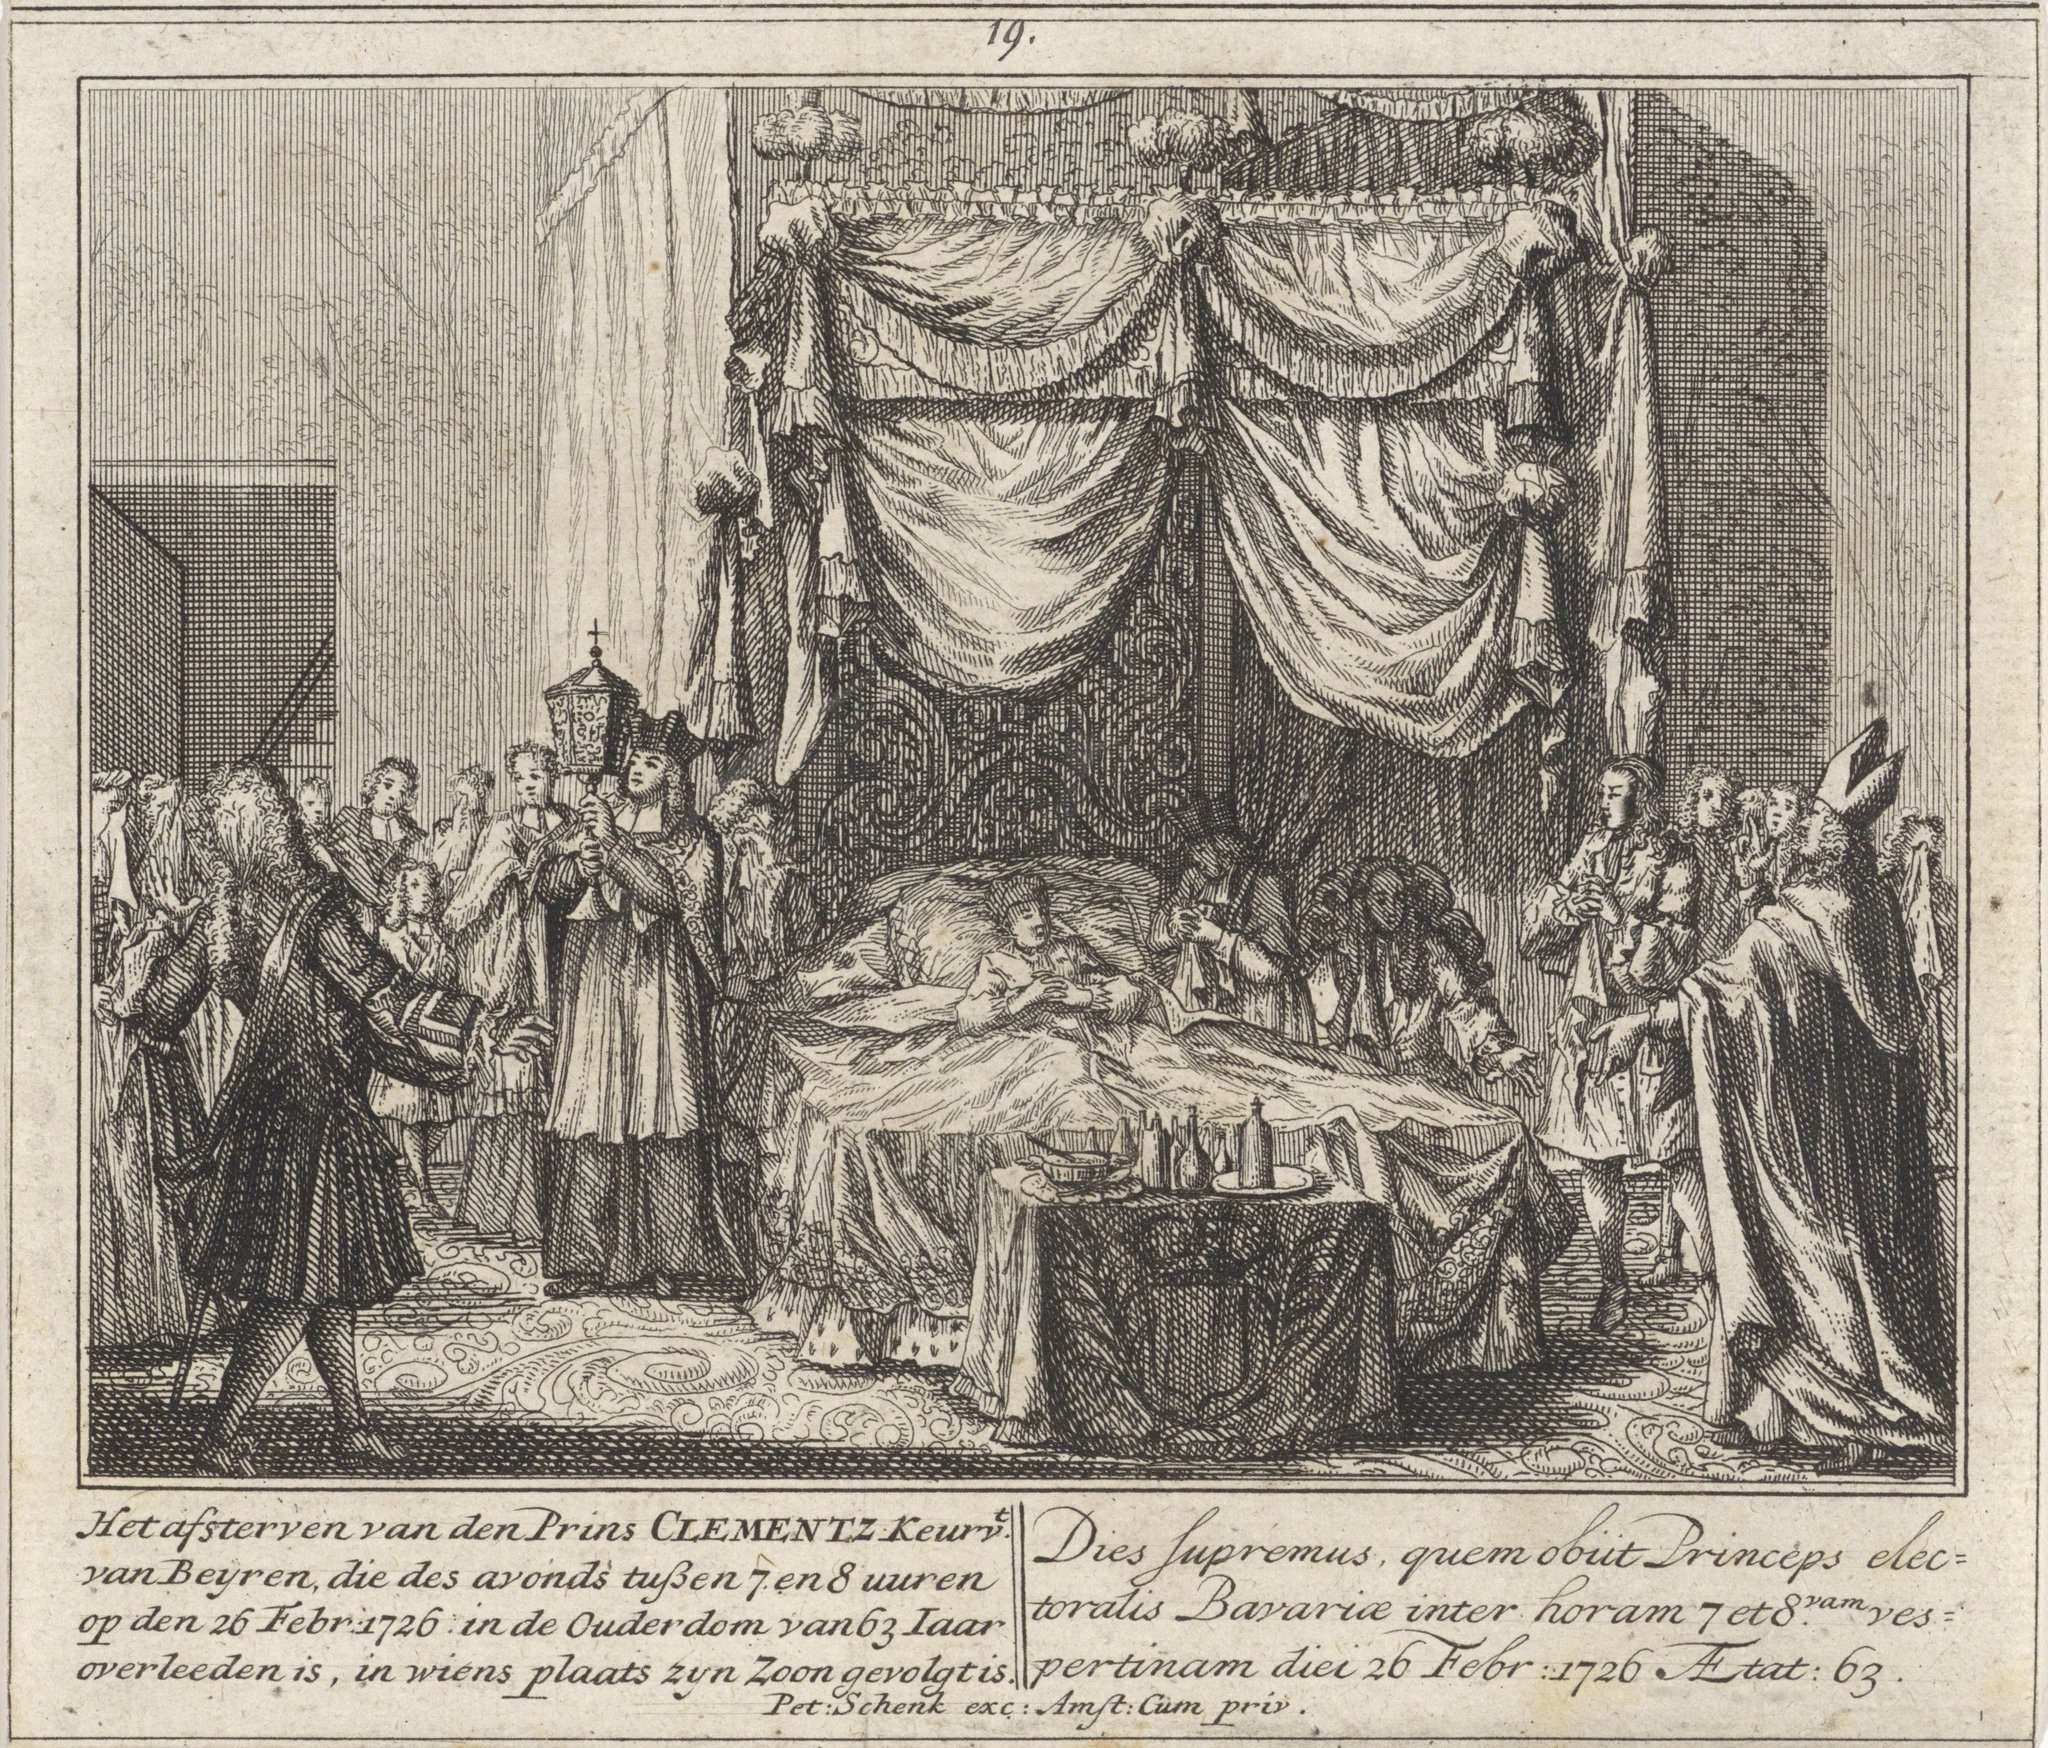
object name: book illustration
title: Het afsterven van den Prins Clementz Keurvt. van Beyren, die des avonds tussen 7 en 8 uuren op den 26 Febr 1726 in de Ouderdom van 63 Iaar overleeden is, in wiens plaats zyn Zoon gevolgt is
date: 1727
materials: paper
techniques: etching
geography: amsterdam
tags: maximiliaan ii emanuel (keurvorst van beieren), deathbed, priest at the bed of a dying person ~ extreme unction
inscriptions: collector's mark: Lugt 2228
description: Het sterfbed van Maximiliaan II Emanuel van Beieren. Een geestelijke dient hem de laatste sacramenten toe. Enkele rouwende hovelingen kijken toe. Linksonder een vierregelige tekst in het Nederlands met een toelichting op de voorstelling en rechts een vergelijkbare, drieregelige toelichting in het Latijn.